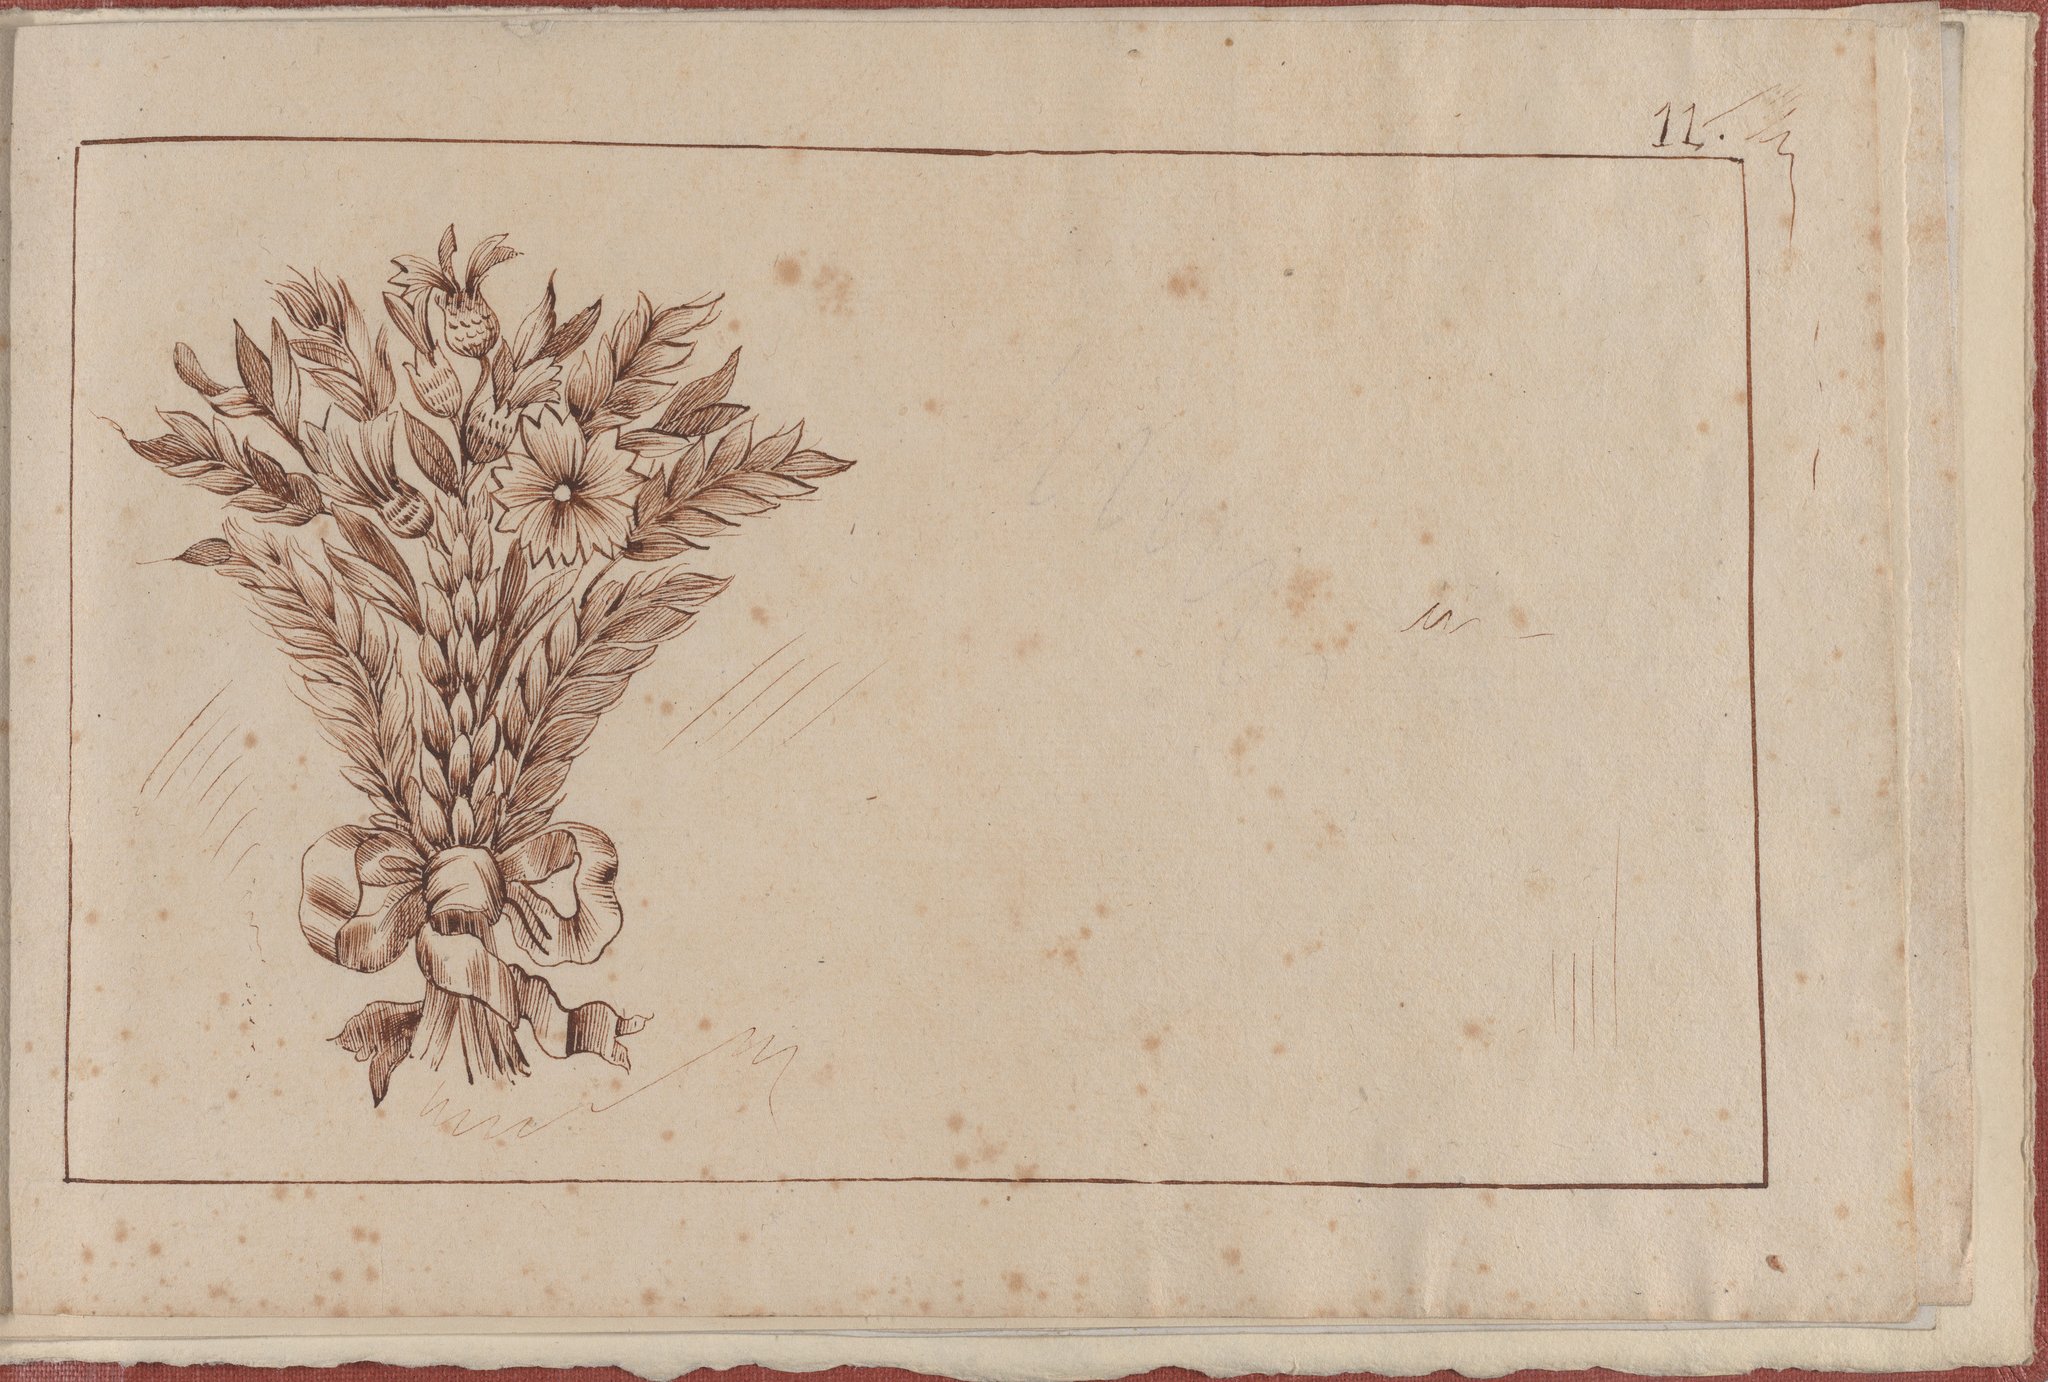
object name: album print ornament architecture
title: Joaillerie: Album of Jewelry Designs, Page 11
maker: anonymous, french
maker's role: artist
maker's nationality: french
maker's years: 1400-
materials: ink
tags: jewelry